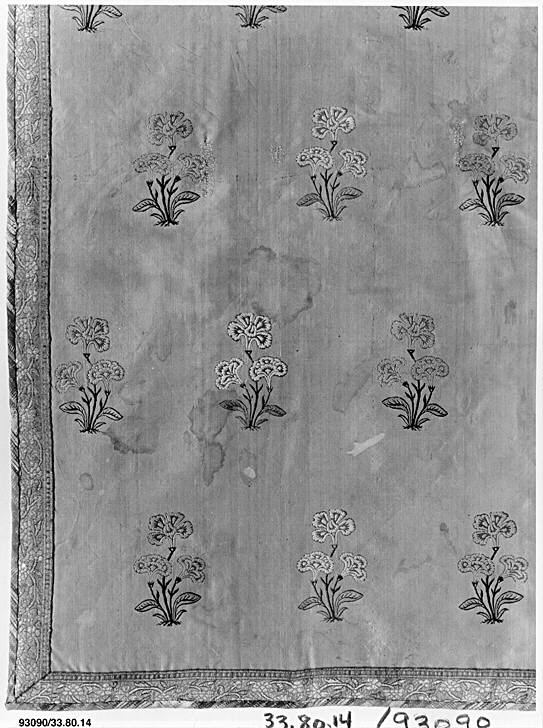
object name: cover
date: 1601-1700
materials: metal thread, silk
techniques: weave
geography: iran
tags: flowers